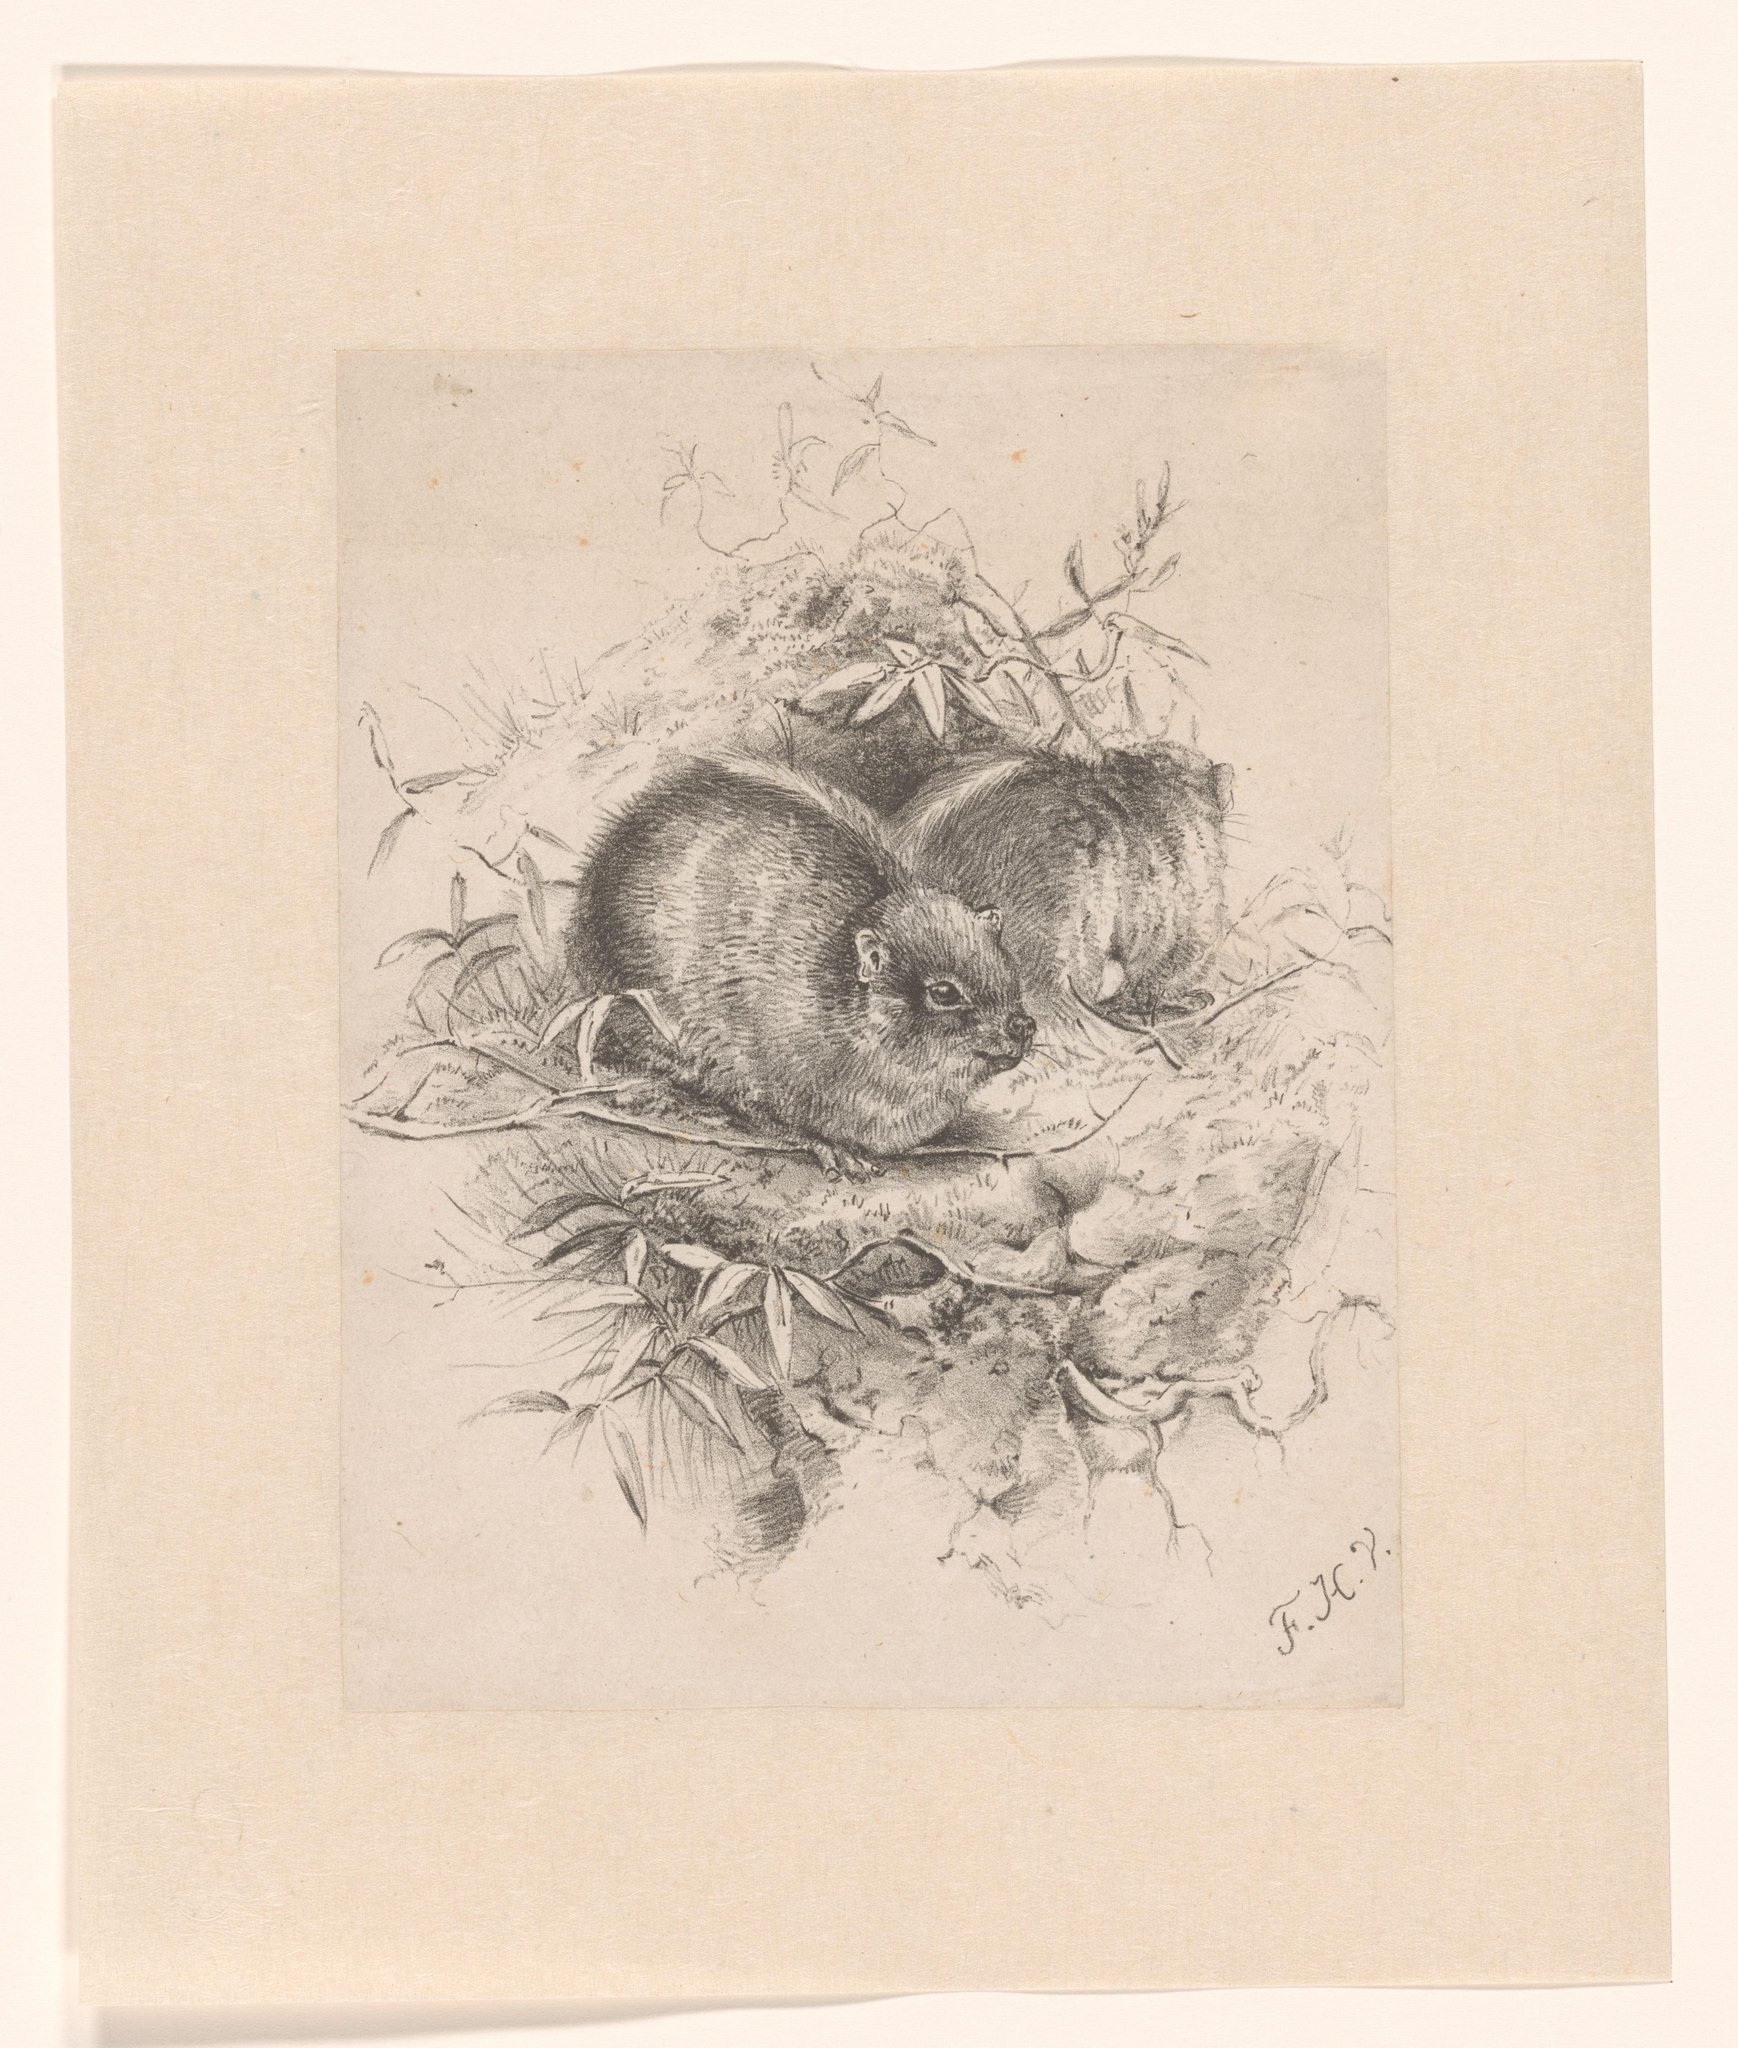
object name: print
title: Twee klipdassen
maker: floris verster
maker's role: draughtsman, painter, print maker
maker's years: 1861-1927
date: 1871-1927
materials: paper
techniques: lithograph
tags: mammals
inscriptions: collector's mark: Lugt 2228